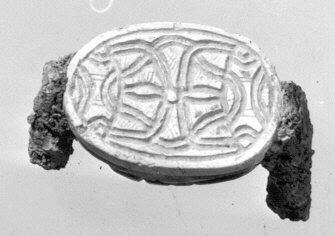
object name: stamp seal ring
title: Scarab seal ring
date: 1700-1560 BCE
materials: stone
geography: levant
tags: scarabs